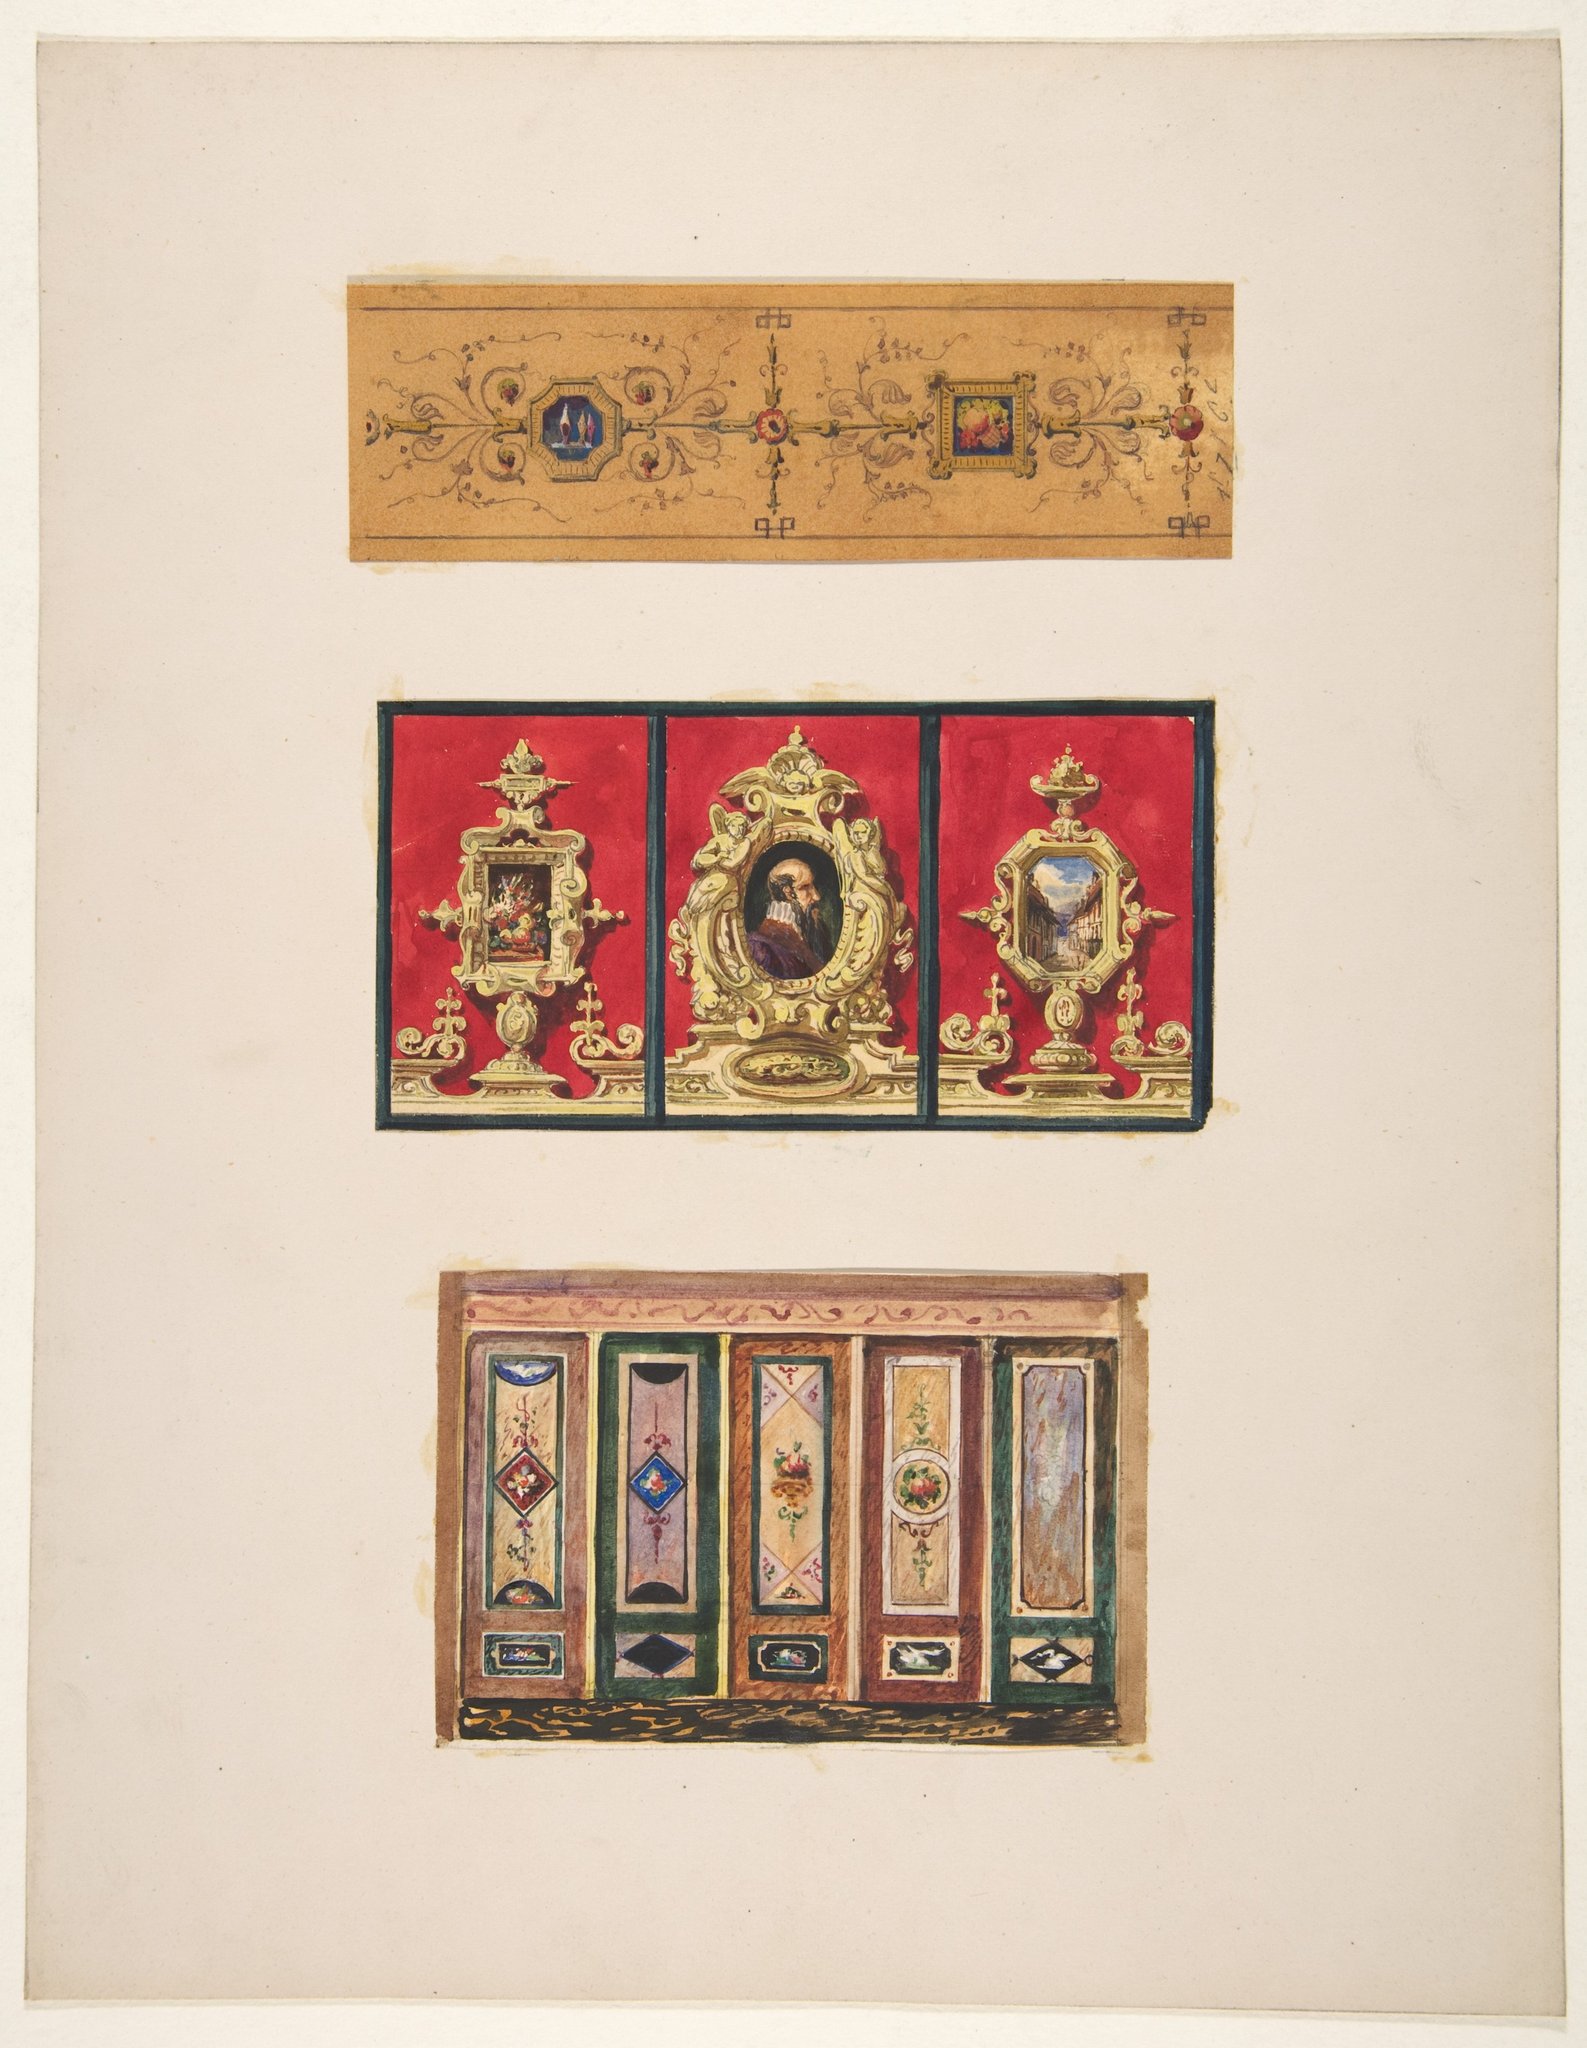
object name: drawing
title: Designs for panels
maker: jules-edmond-charles lachaise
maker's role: artist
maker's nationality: french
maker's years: 1897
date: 1801-1900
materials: gold paint, graphite, ink, paper, watercolor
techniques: pen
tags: buildings,fruit,men,profiles